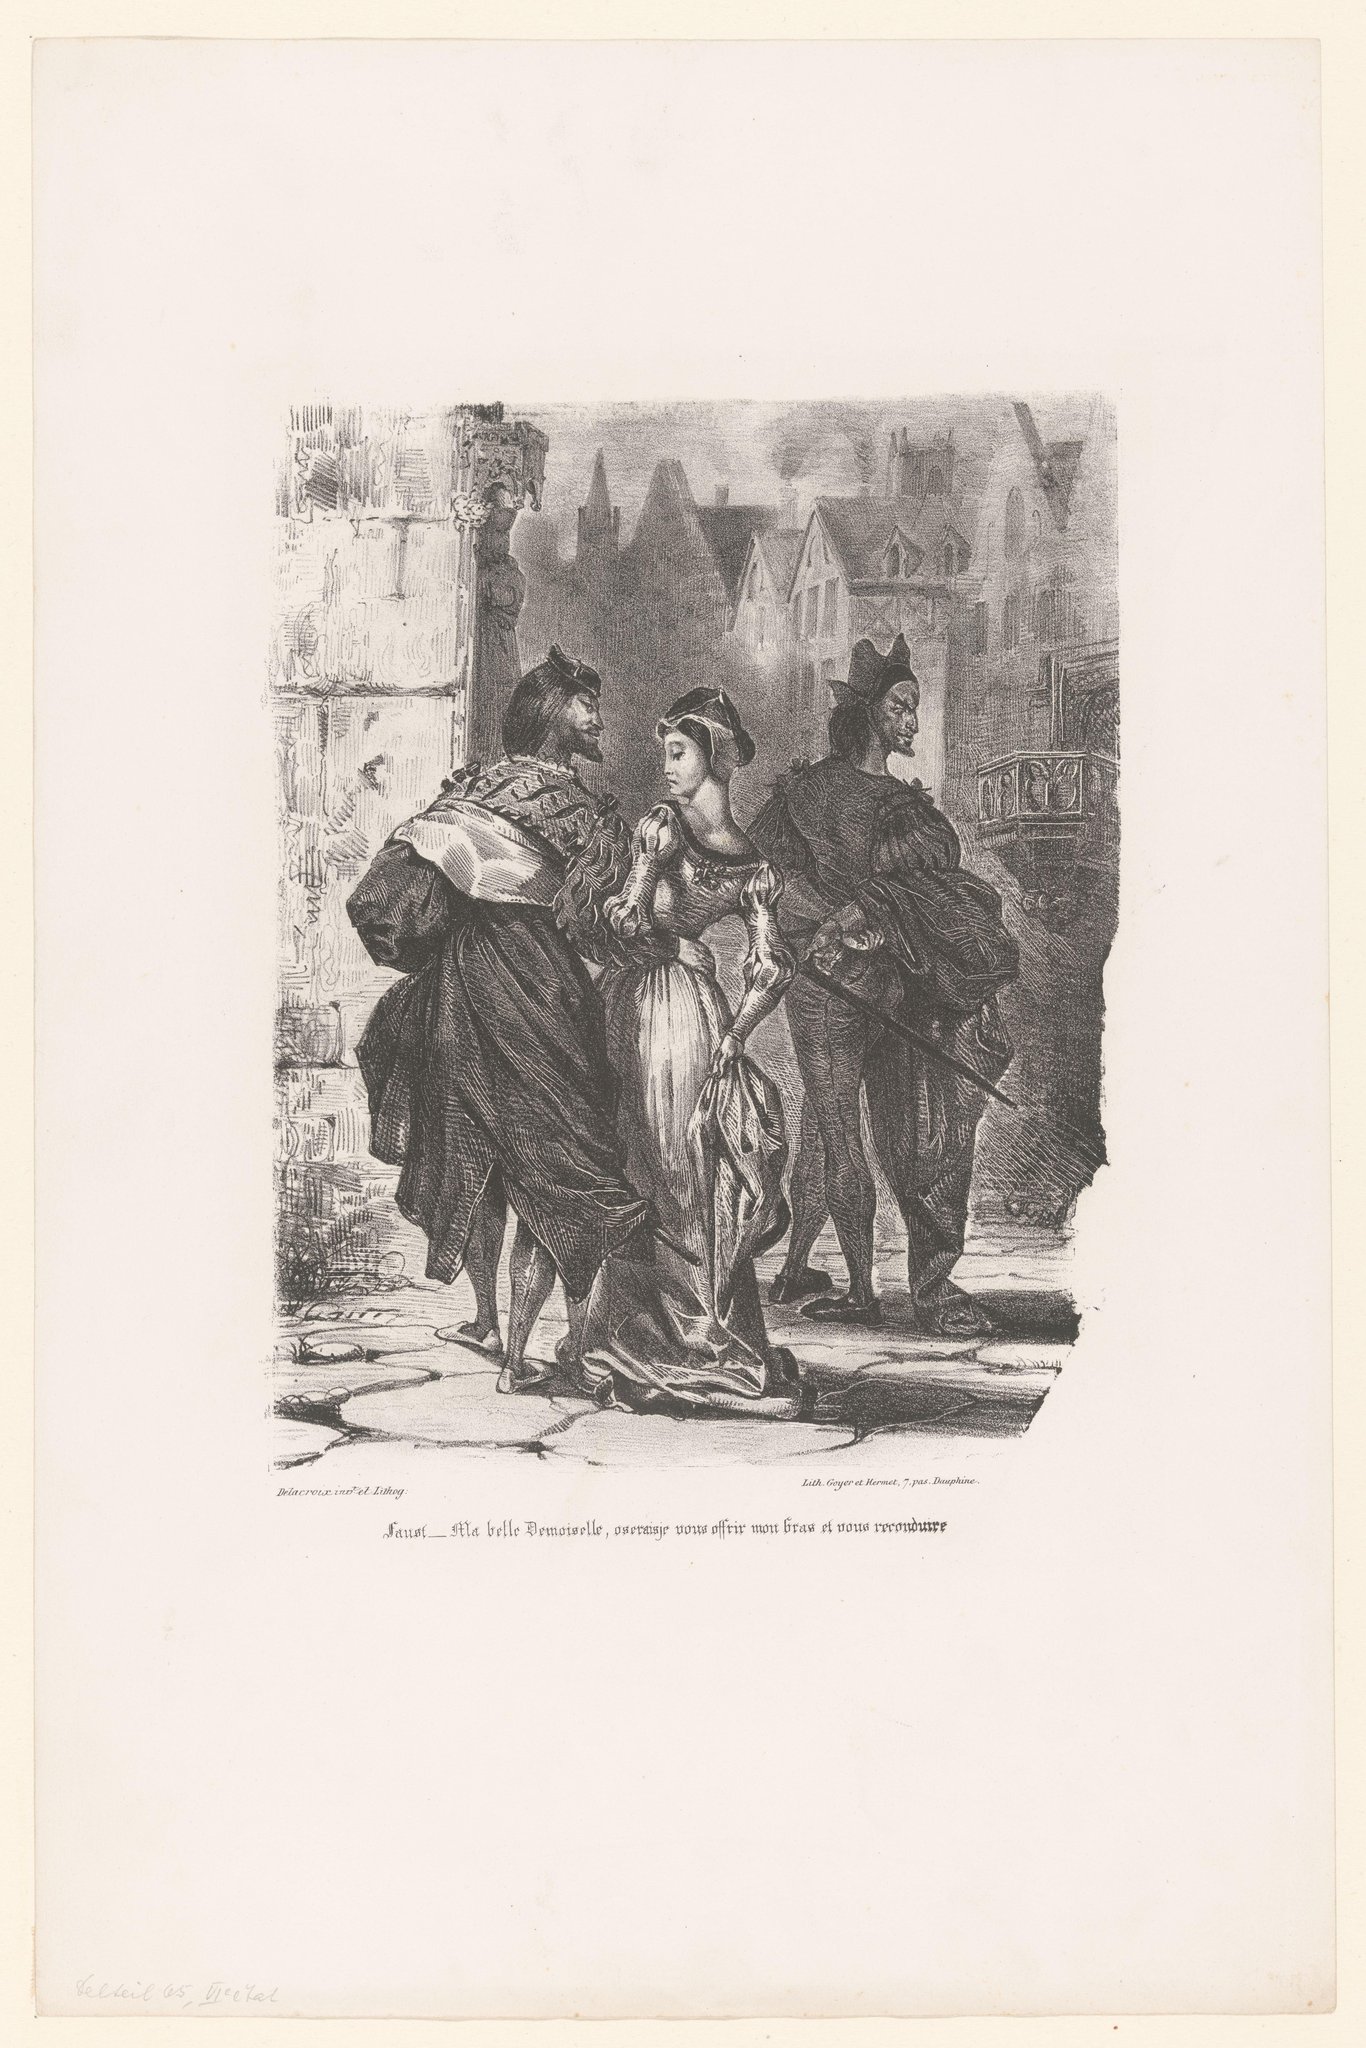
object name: print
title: Faust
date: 1828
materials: paper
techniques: lithograph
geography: paris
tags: (scenes from) specific works of literature: goethe, faust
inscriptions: collector's mark: Lugt 2228a, collector's mark: Lugt 964